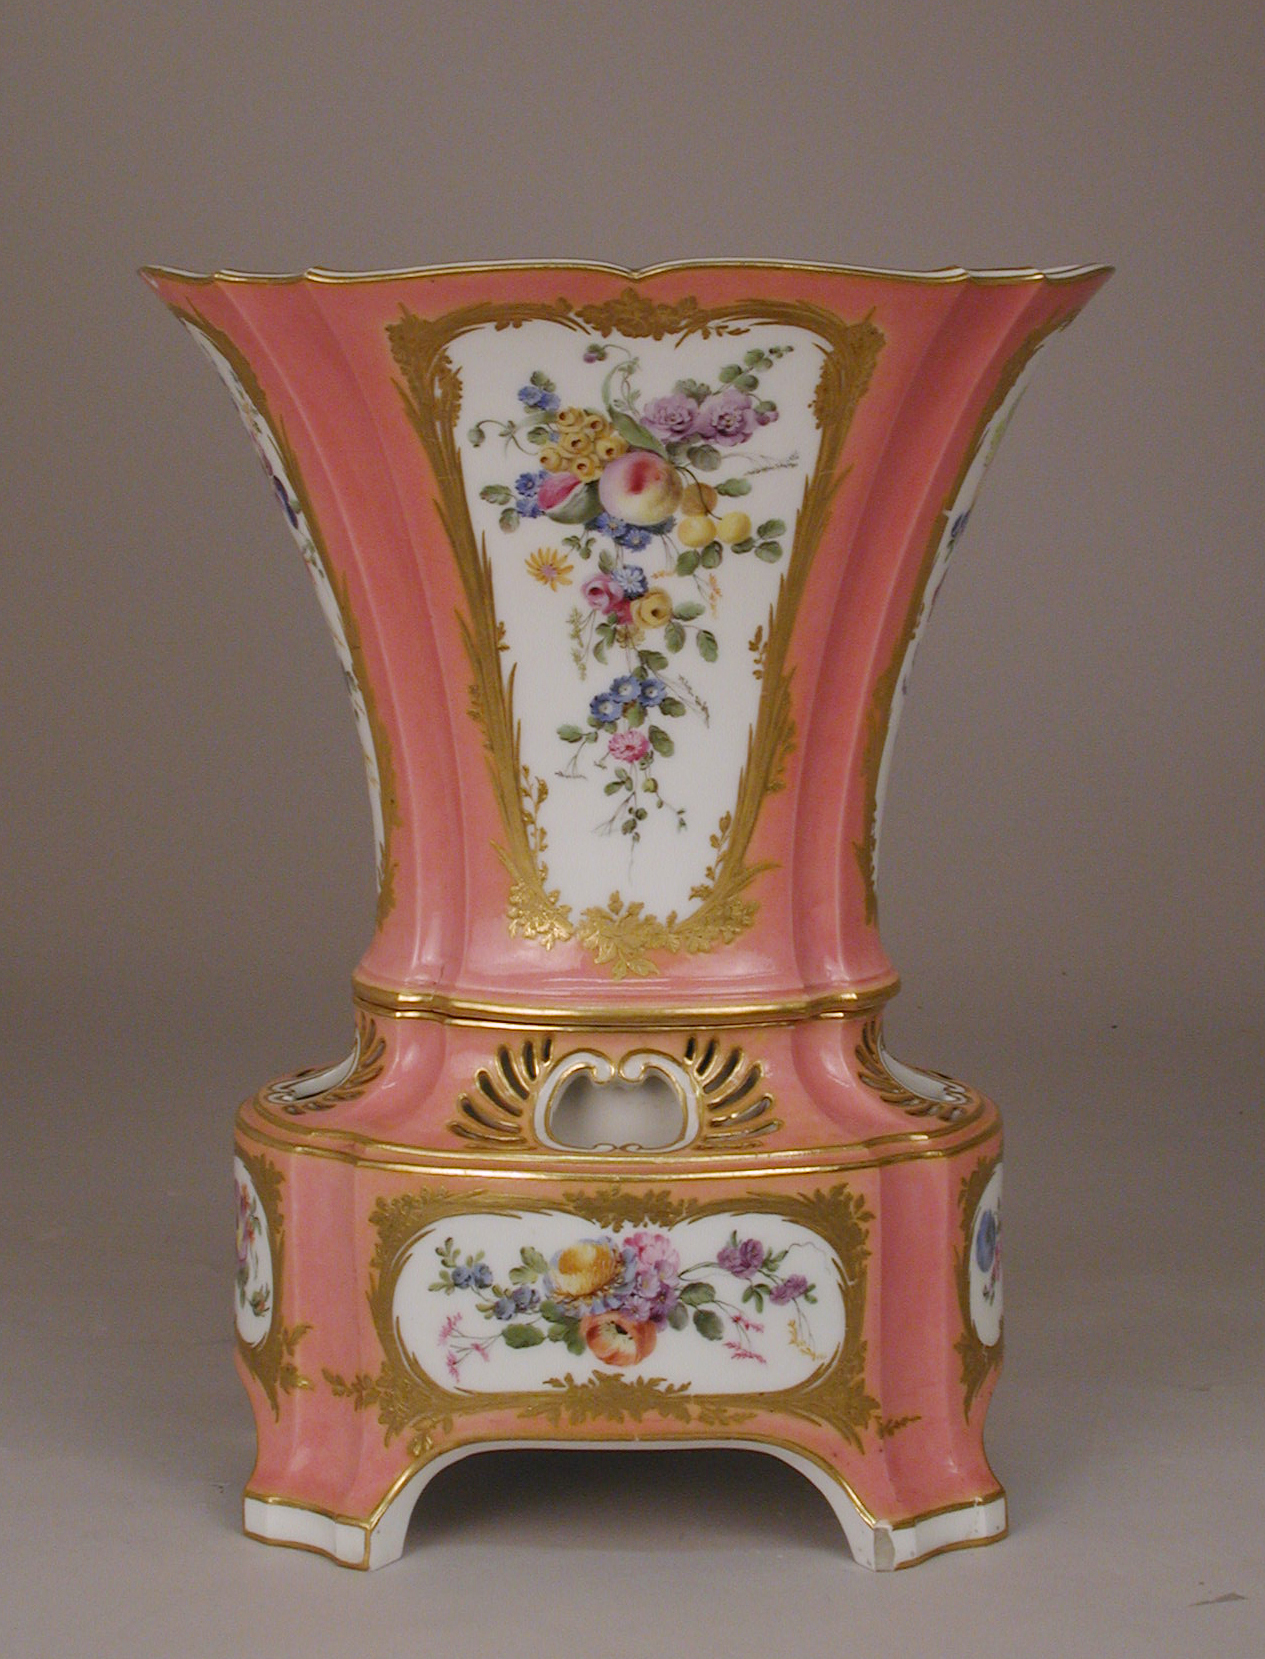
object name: vase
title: Vase (vase hollandois nouveau ovale) (one of a pair) (part of a set)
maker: sèvres manufactory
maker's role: manufactory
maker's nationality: french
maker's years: 1740-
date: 1763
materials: soft paste porcelain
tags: fruit,flowers